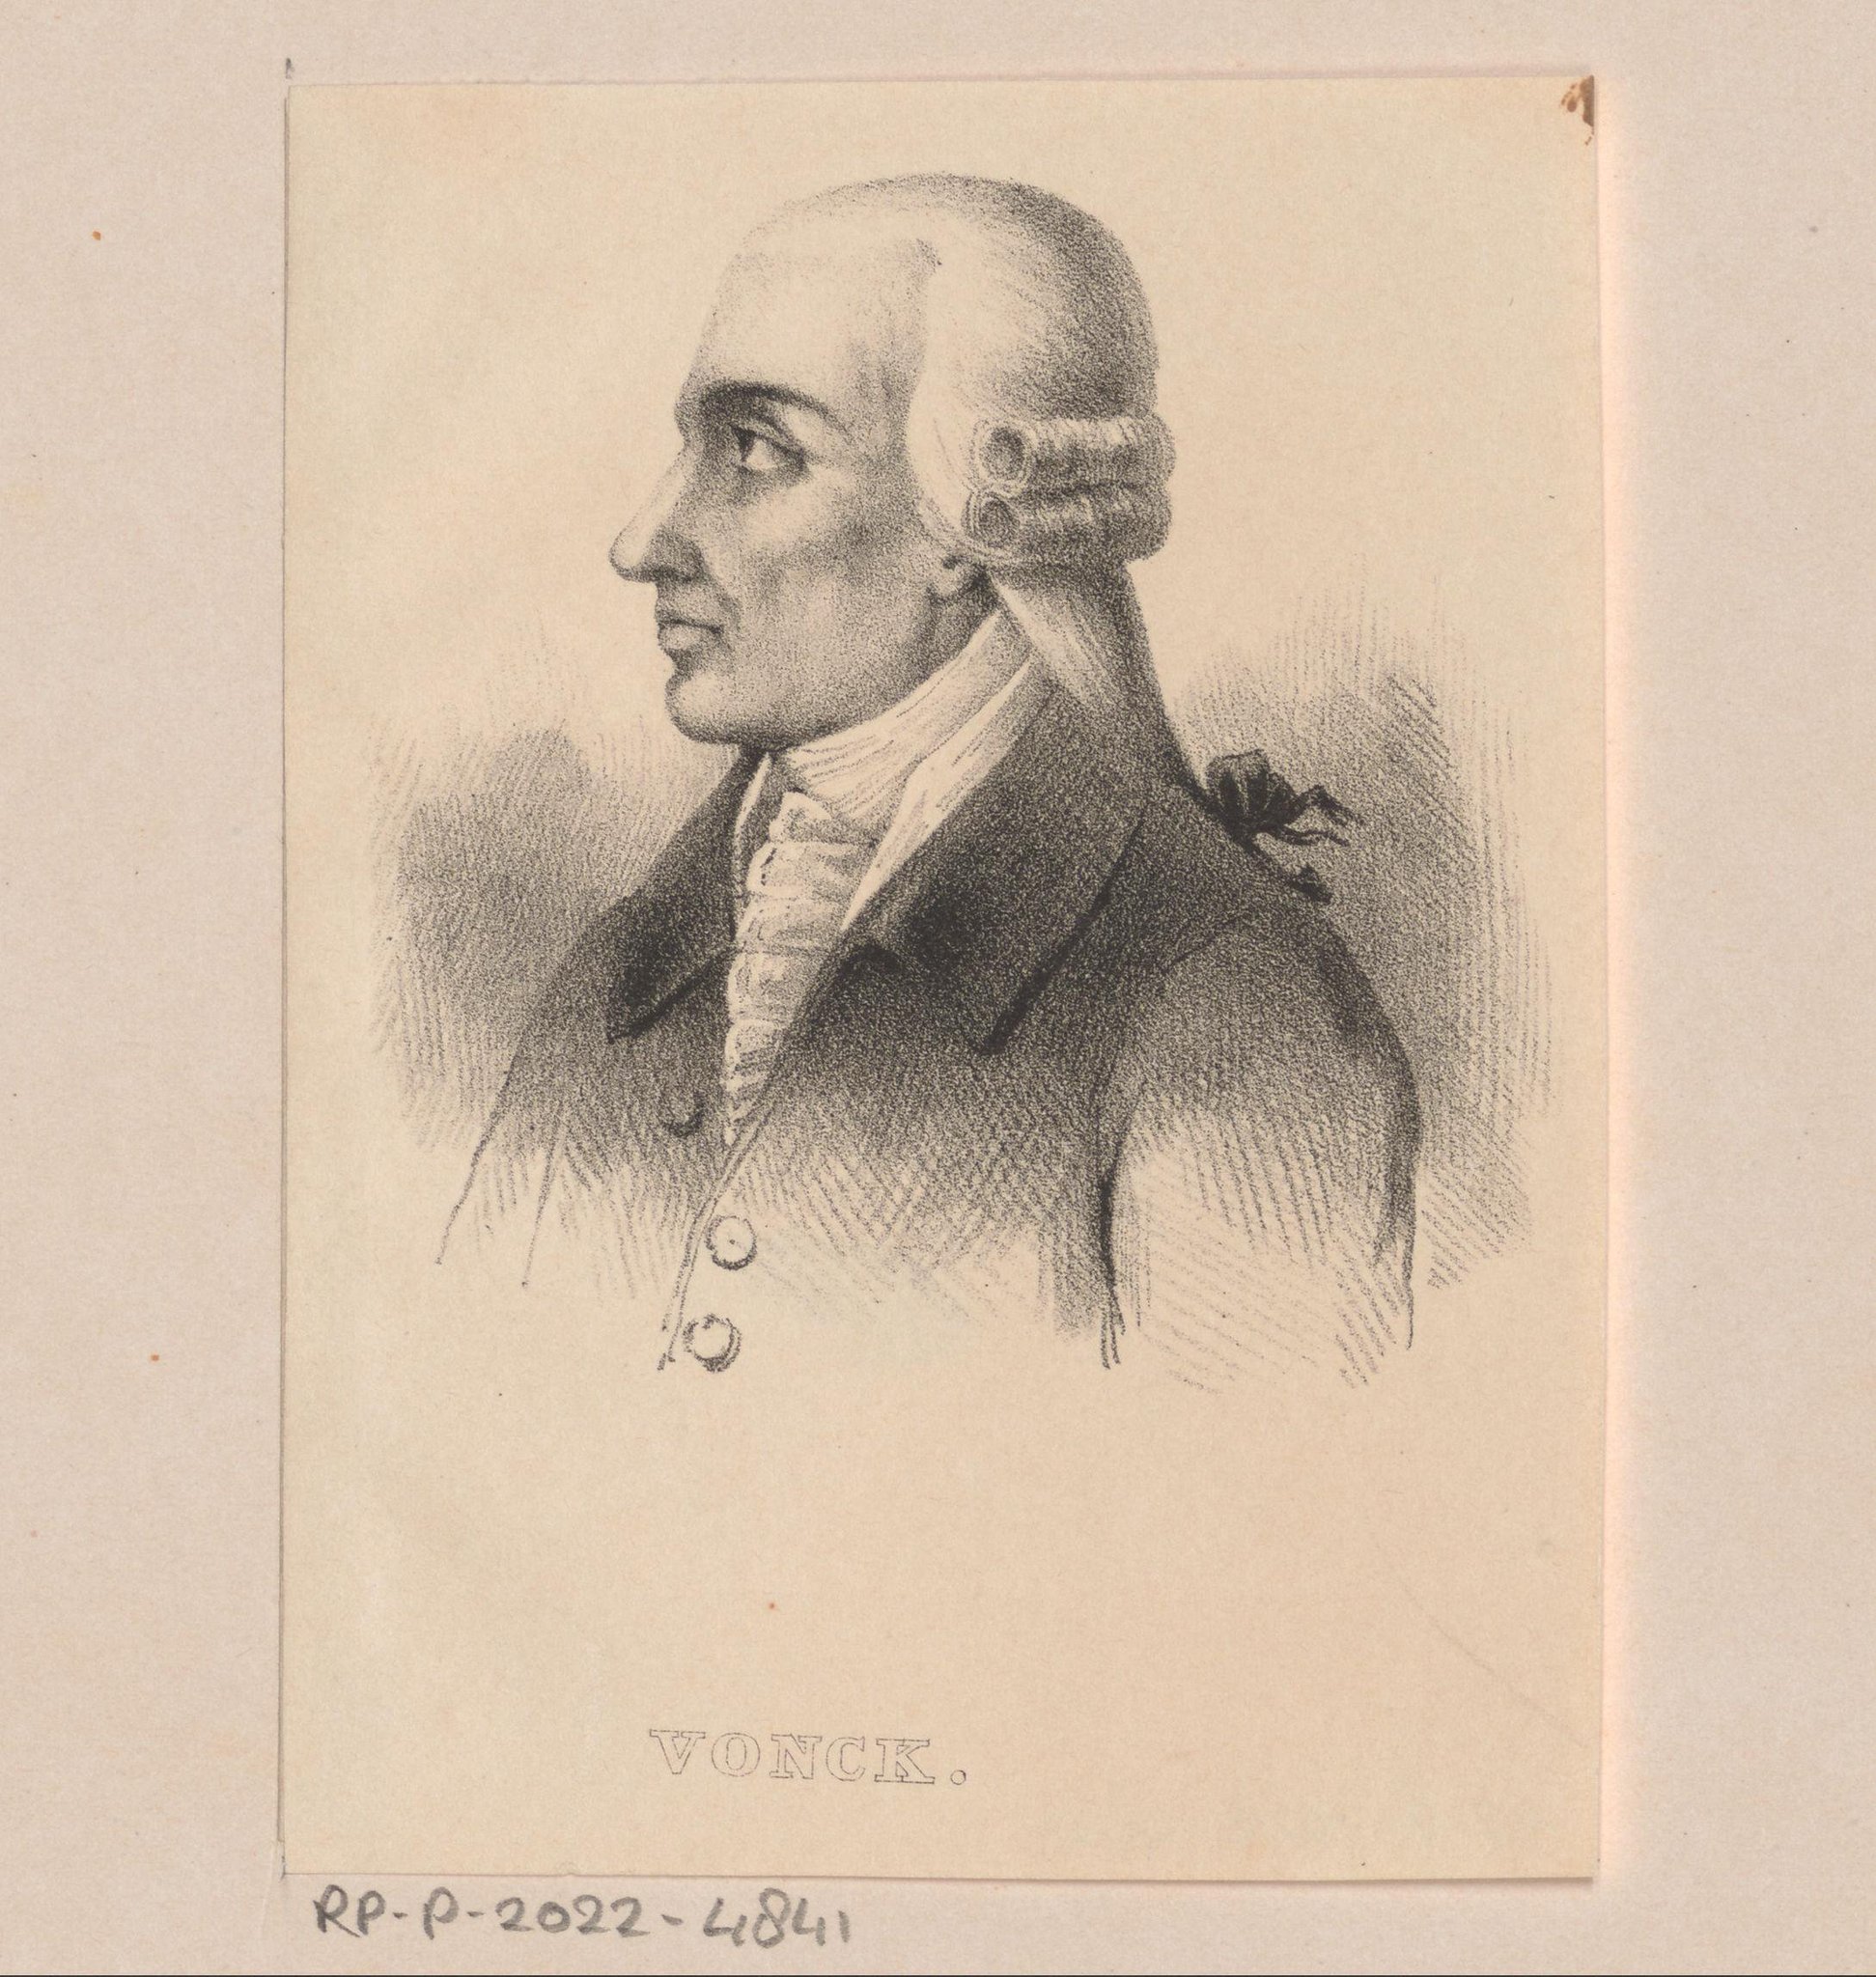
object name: print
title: Portret van een man, mogelijk Lambertus Christoffel Vonck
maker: Anonymous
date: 1800-1850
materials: paper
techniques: lithograph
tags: rotterdam, the hague, historical persons, portrait of a writer, politician, e.g. party leader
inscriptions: collector's mark: Lugt 2228